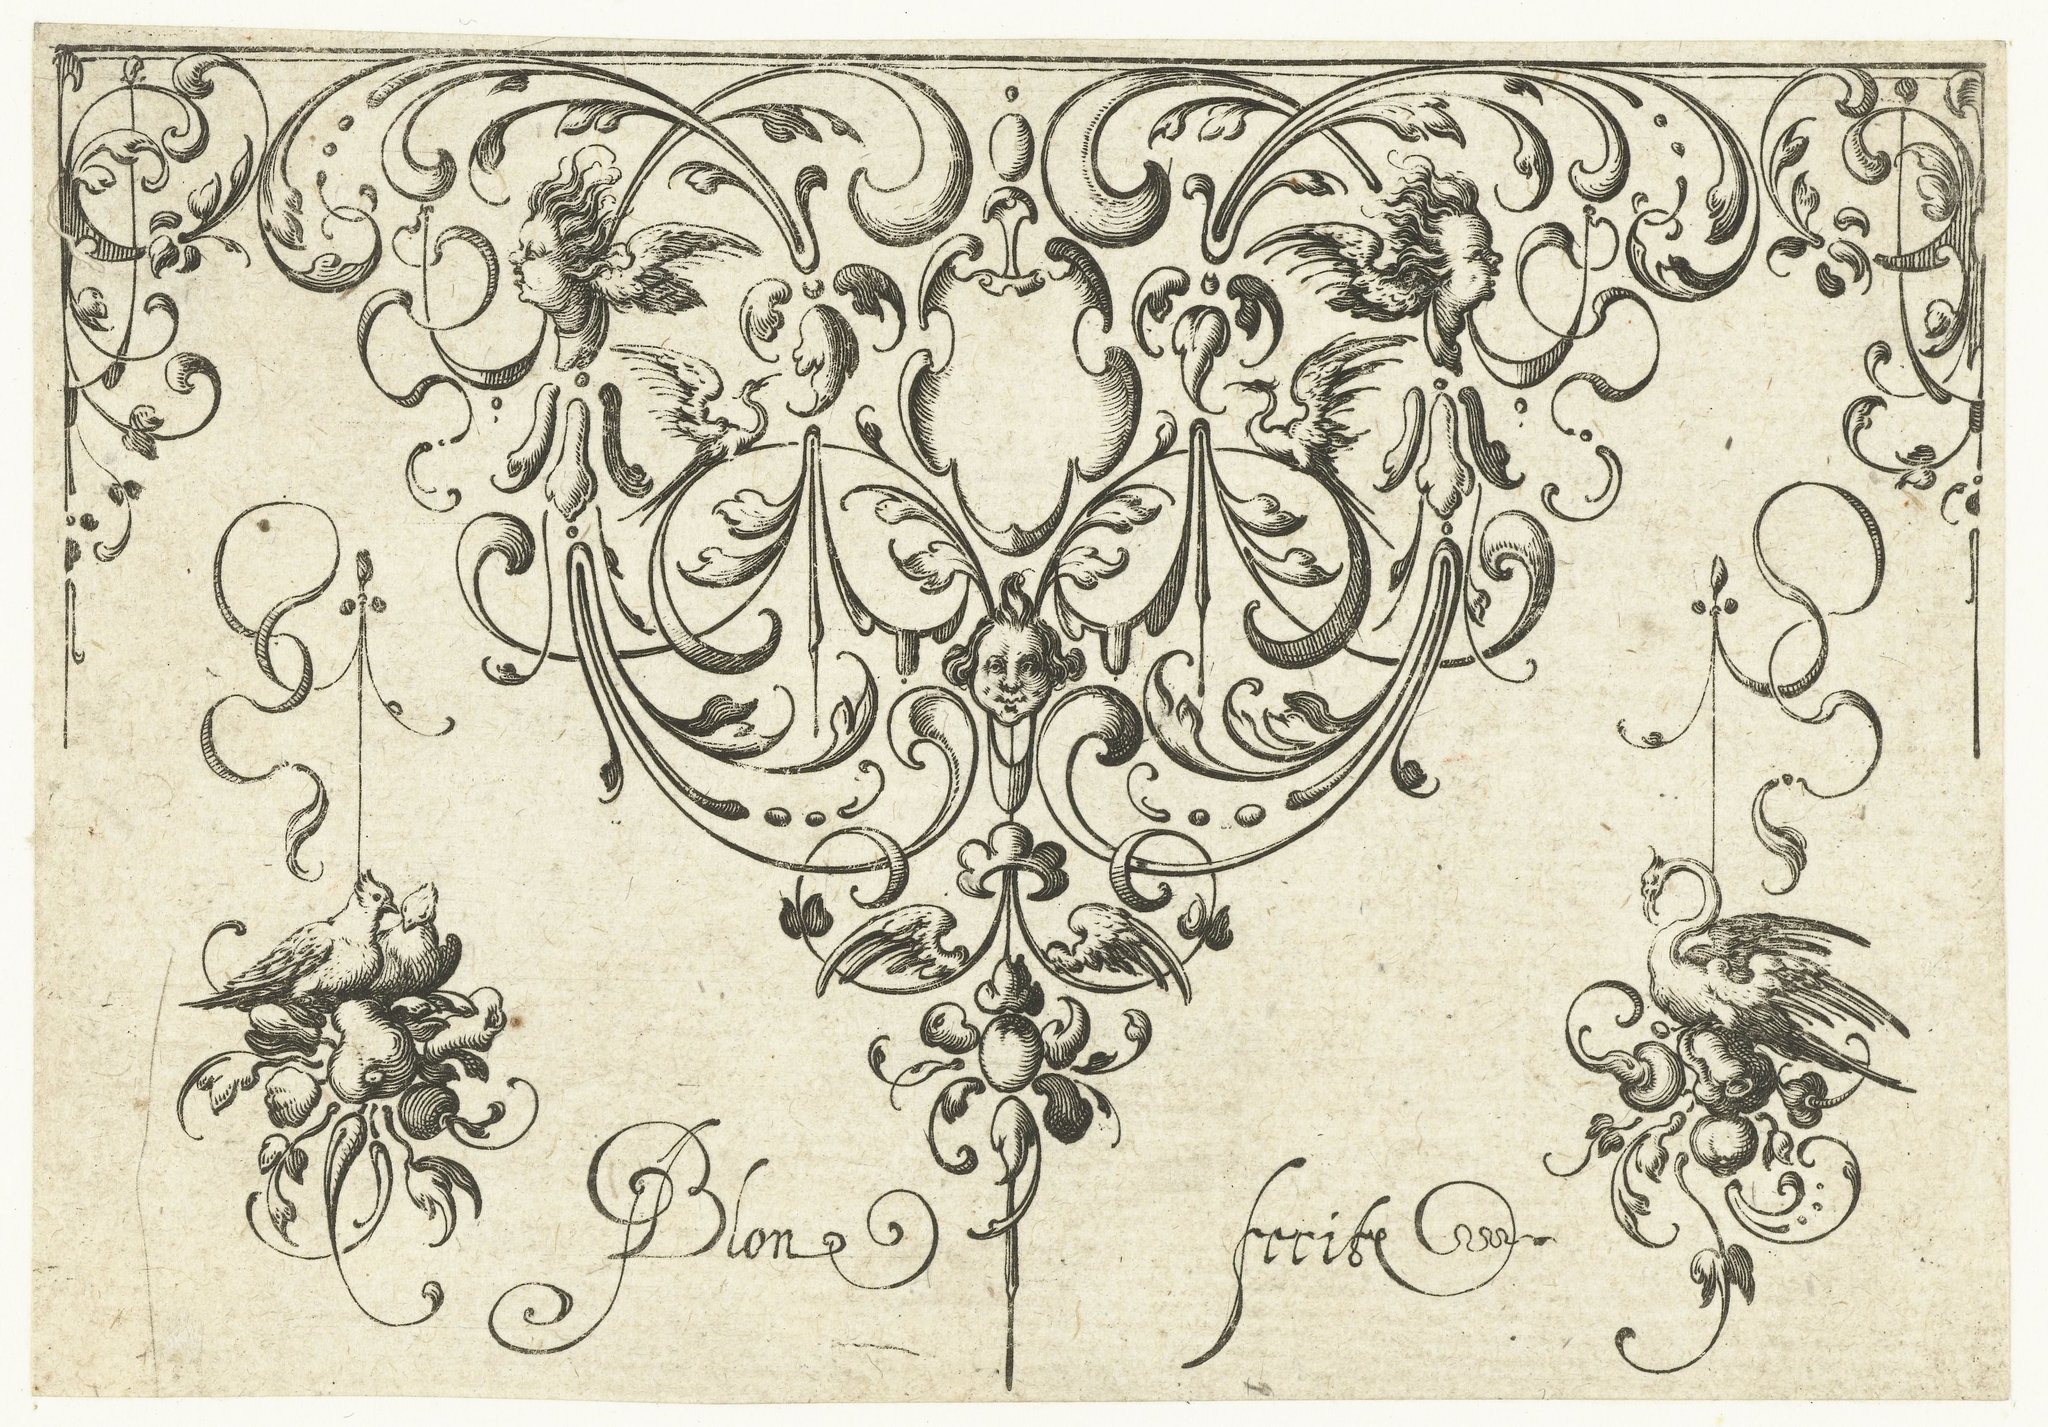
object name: print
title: Rand met een lege cartouche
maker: michiel le blon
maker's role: print maker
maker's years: 1587-1656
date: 1611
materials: paper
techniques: etching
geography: amsterdam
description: Blad 5 uit serie van 14 bladen met voorbeelden voor gegraveerde decoratieranden van bekers in de vorm van driehoeken bestaande uit ranken, Schweifwerk, guirlandes met putti, dieren, vogels en maskers.